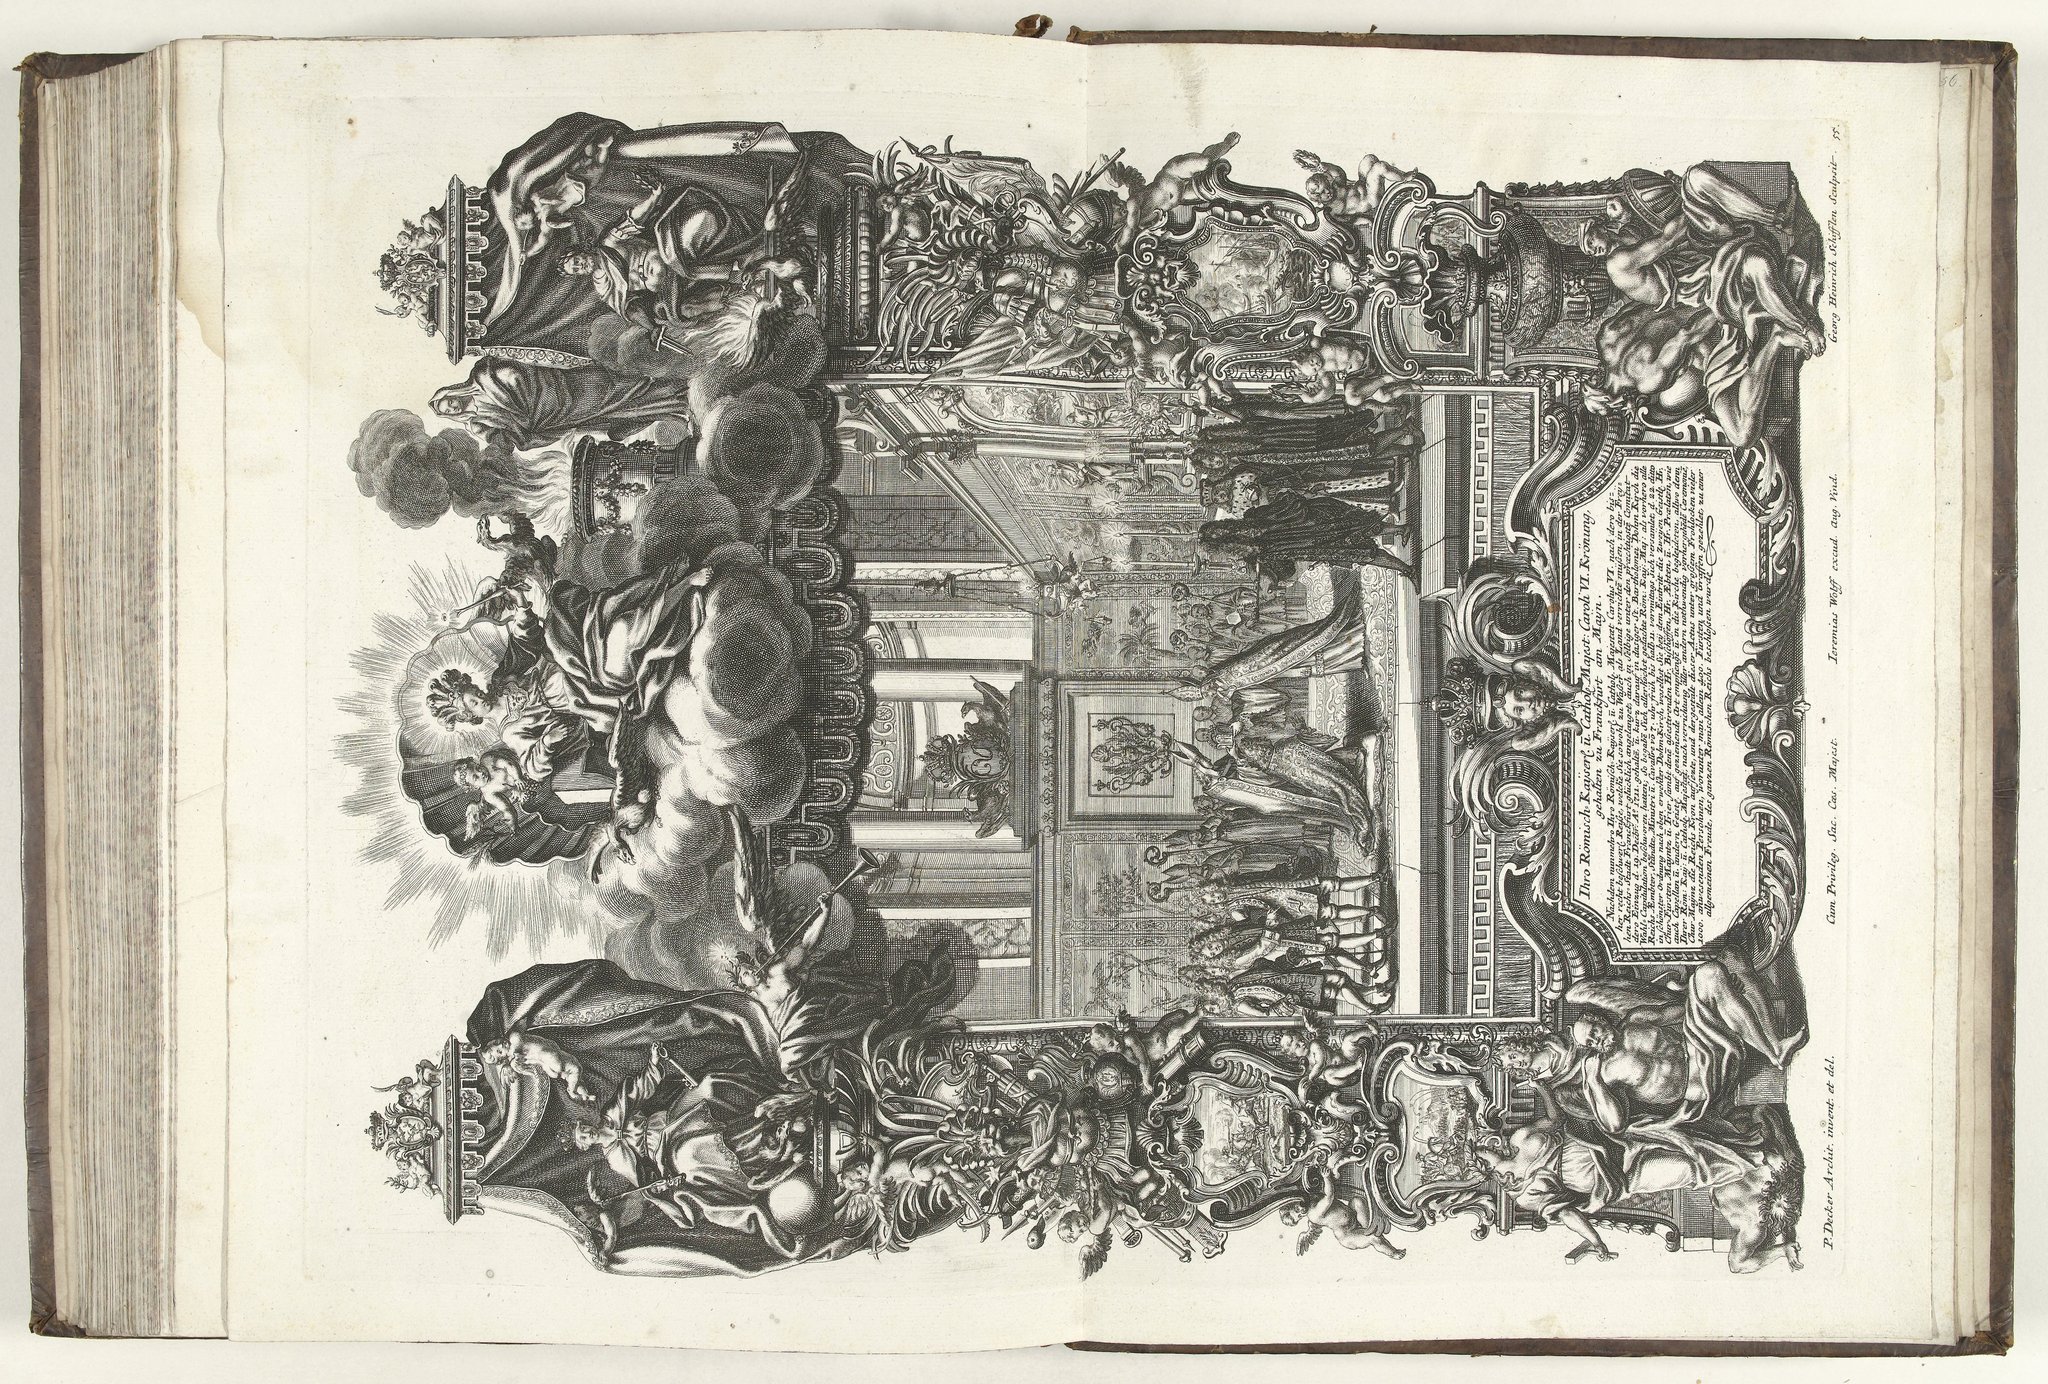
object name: history print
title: Ihro Römisch-Kaiserl. u. Cathol. Majest: Caroli VI. Krönung, gehalten zu Frankfurt am Mayn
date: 1712-1715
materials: paper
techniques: engraving, etching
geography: augsburg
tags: charles vi (holy roman emperor), during the coronation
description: Kroning van koning Karel III van Spanje (aartshertog Karel van Oostenrijk) tot Duits keizer Karel VI, 22 december 1711. De centrale voorstelling van de kroning gevat in een zeer rijk versierde ornamentele omlijsting met wapentrofeeën en allegorische figuren. Onderaan een cartouche met de beschrijving van de gebeurtenissen in het Duits. Blad in de gebonden verzameling platen uitgebracht onder de titel: Repraesentatio belli ... Der Spanische Successions-Krieg [ca. 1720].